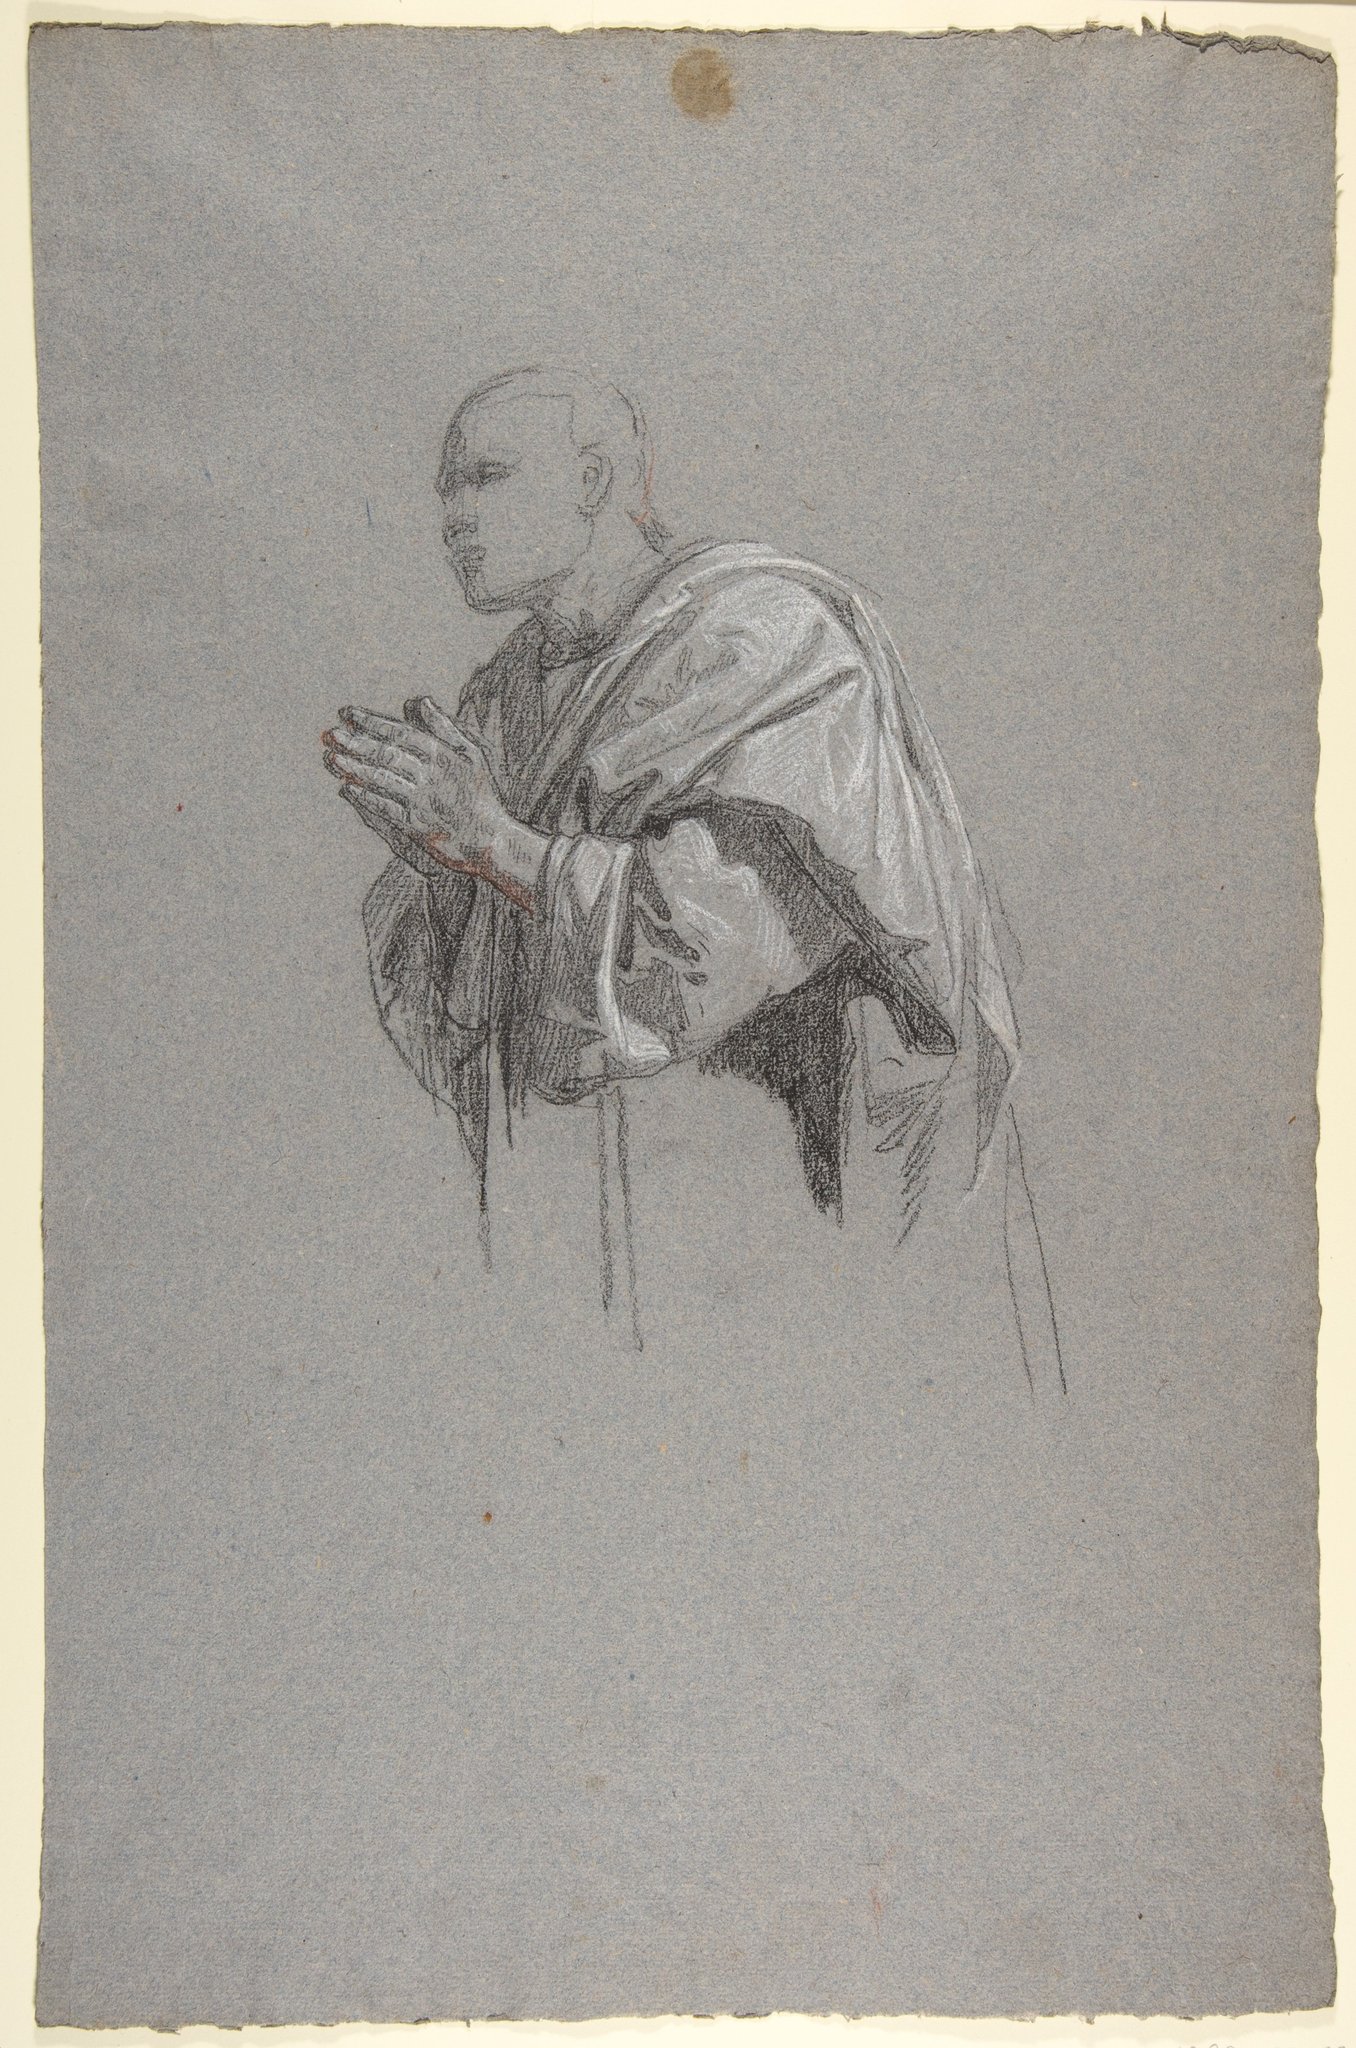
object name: drawing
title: Drapery Study for a Cleric (lower register; study for wall paintings in the Chapel of Saint Remi, Sainte-Clotilde, Paris, 1858)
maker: isidore pils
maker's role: artist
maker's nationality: french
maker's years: 1813-1875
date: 1801-1900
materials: chalk, paper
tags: men